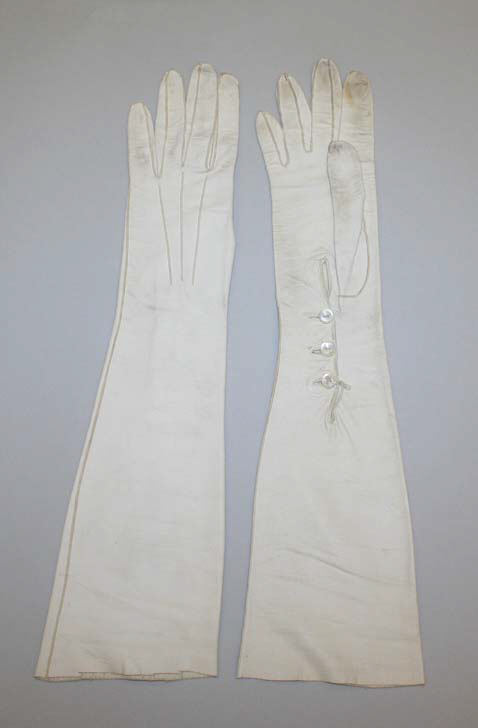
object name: wedding glove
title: Wedding gloves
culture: american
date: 1887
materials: leather, pearl